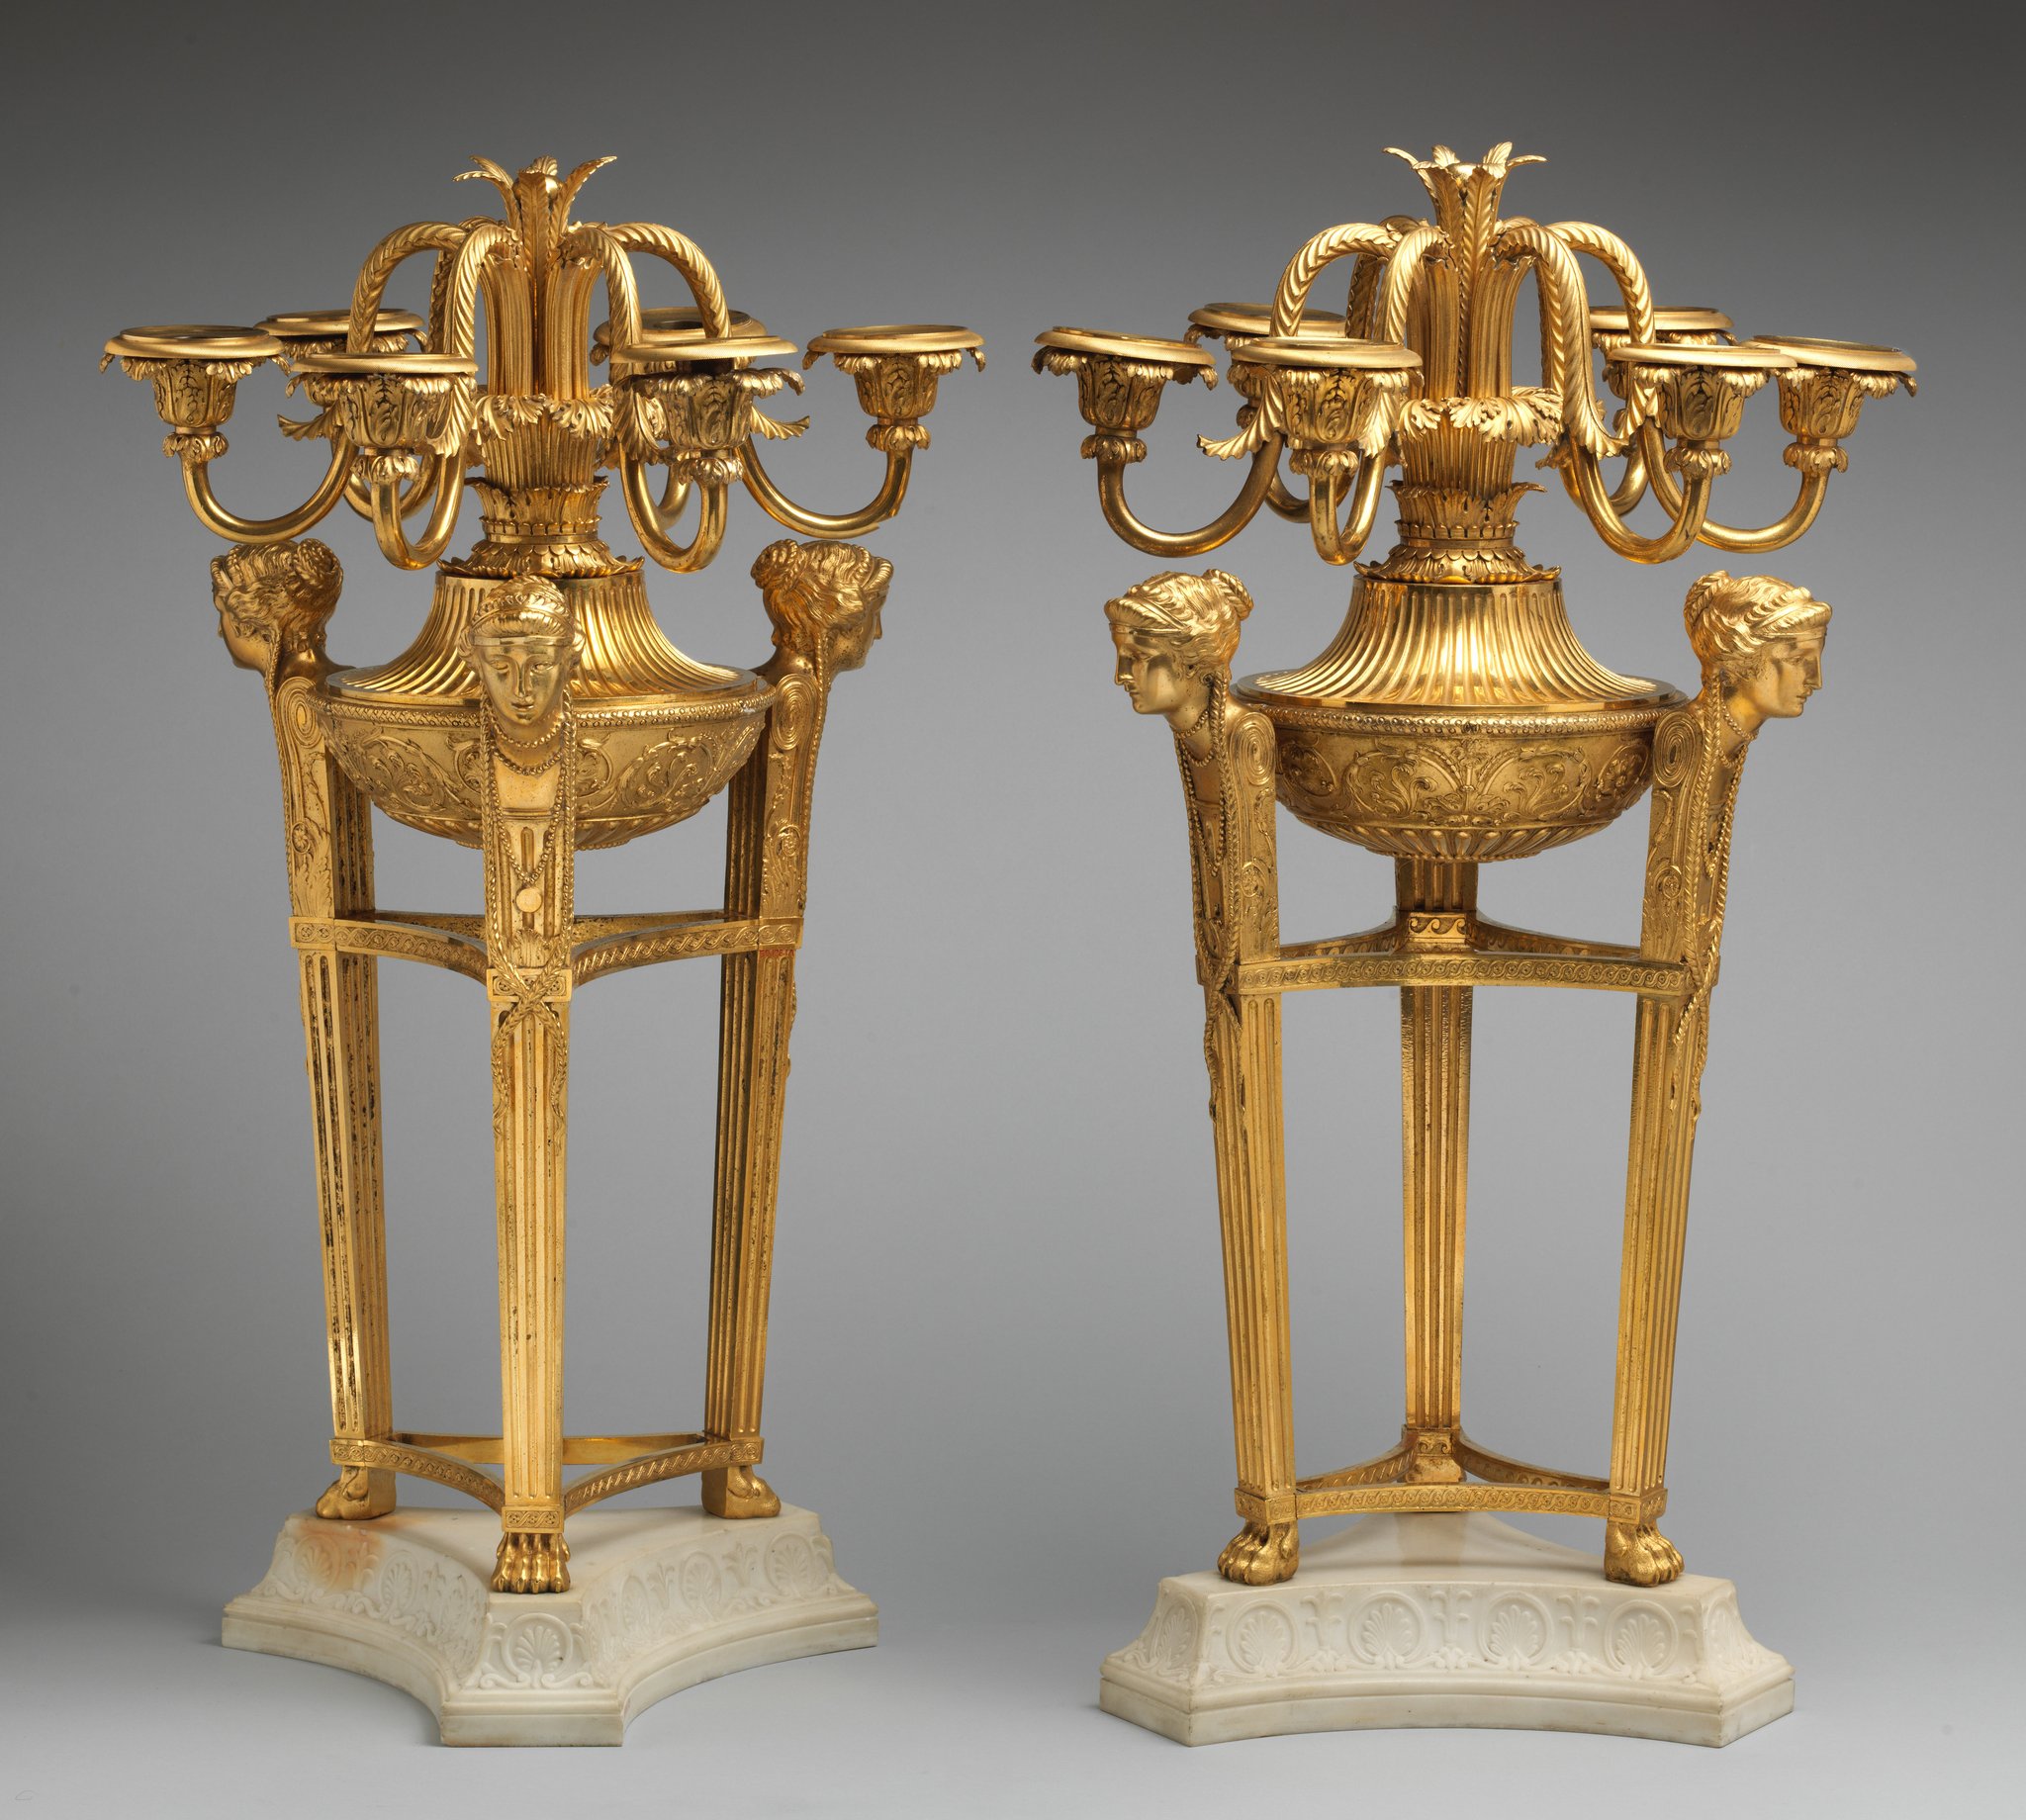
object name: candelabrum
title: Pair of candelabra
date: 1770-1780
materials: wood, gilt bronze, marble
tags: heads